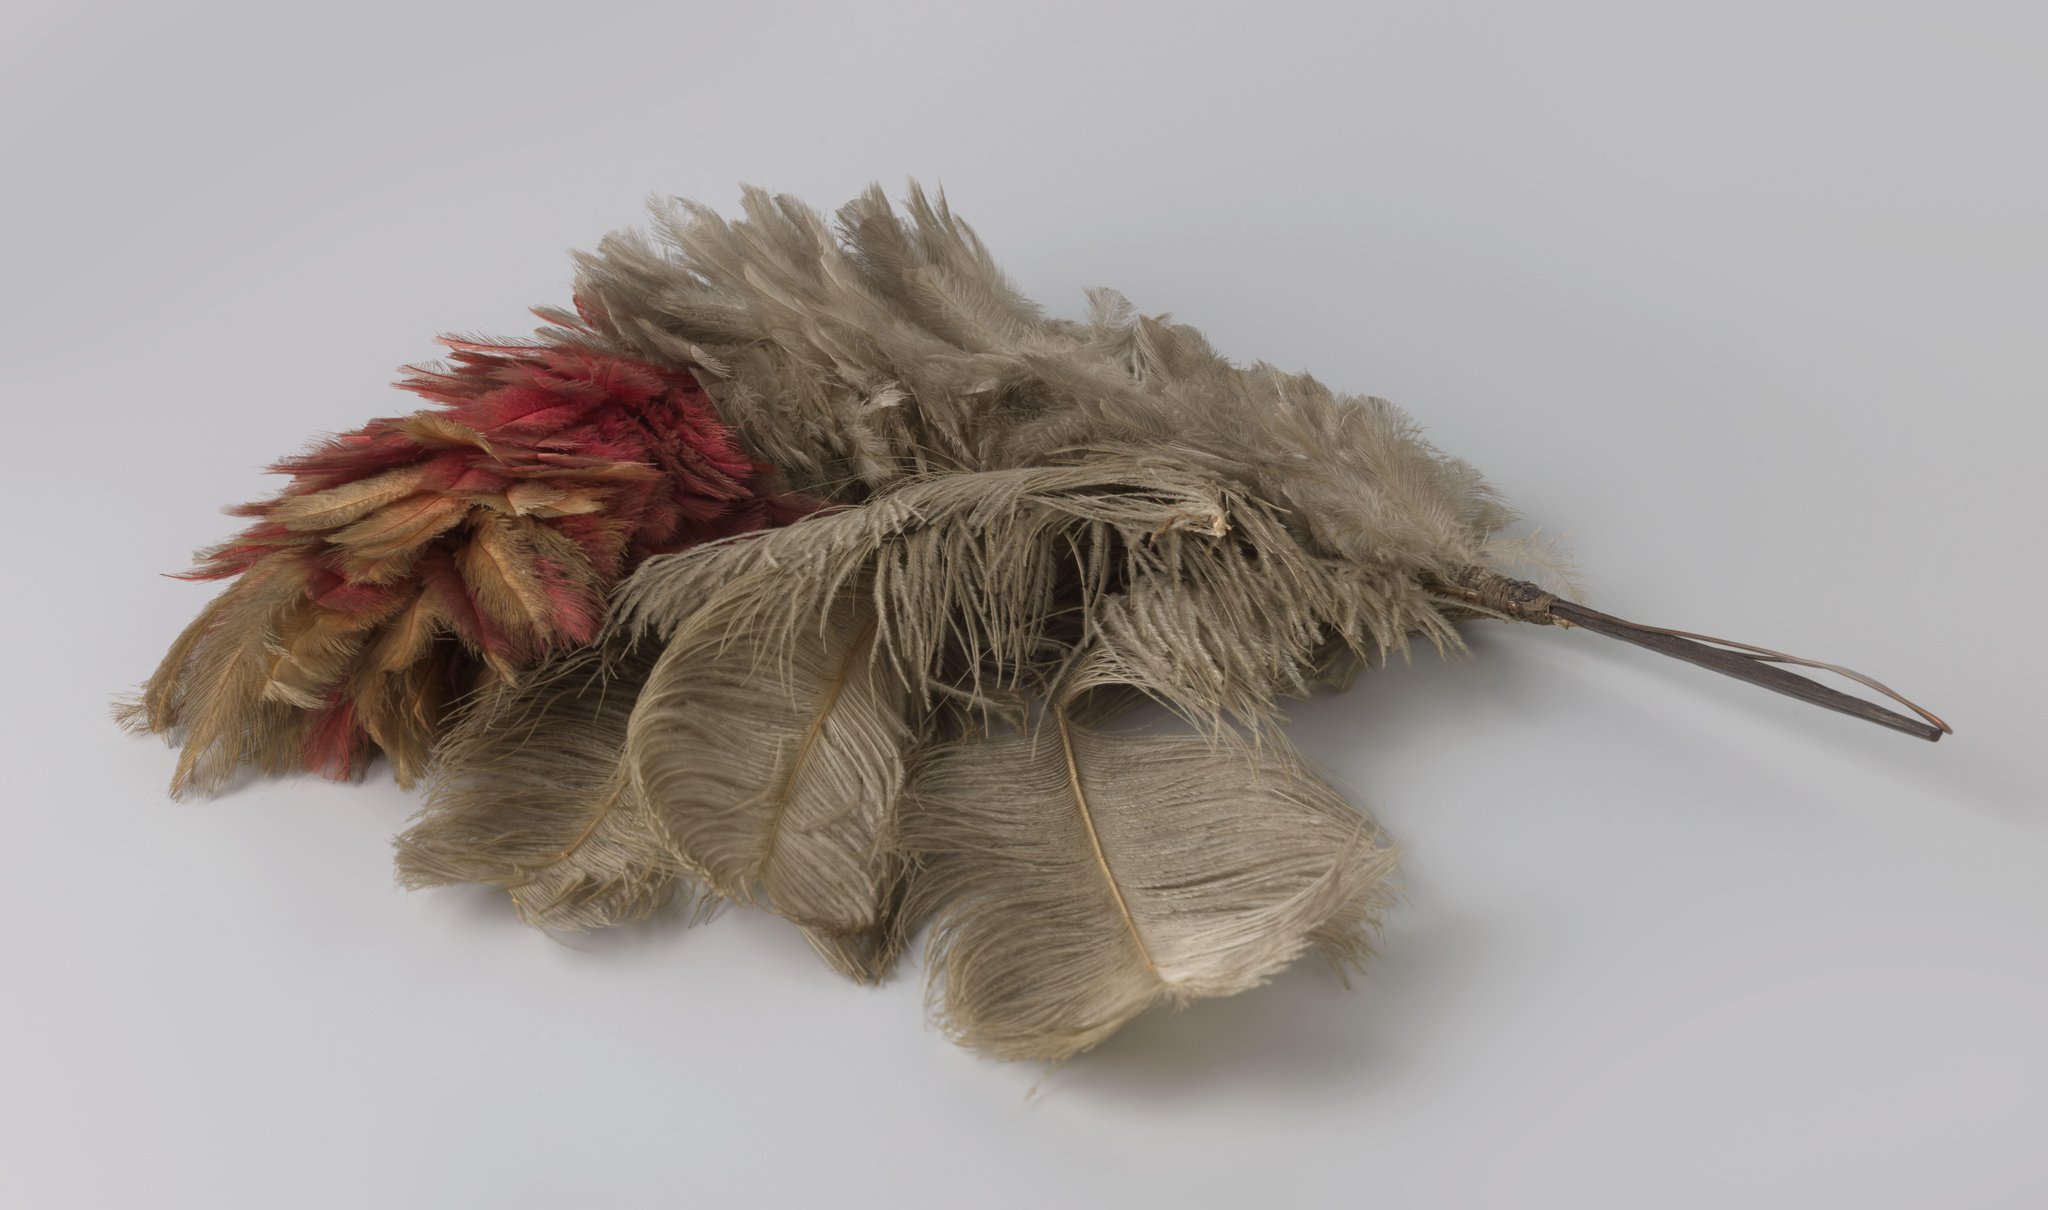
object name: plume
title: Pluim van struisvogelveren horend bij kolbak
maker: Anonymous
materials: ostrich feather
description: Zilverwitte struisvogelveren pluim, aan het einde rood en geel, op een stokje. De pluim hoort bij kolbak NG-NM-10385-184.